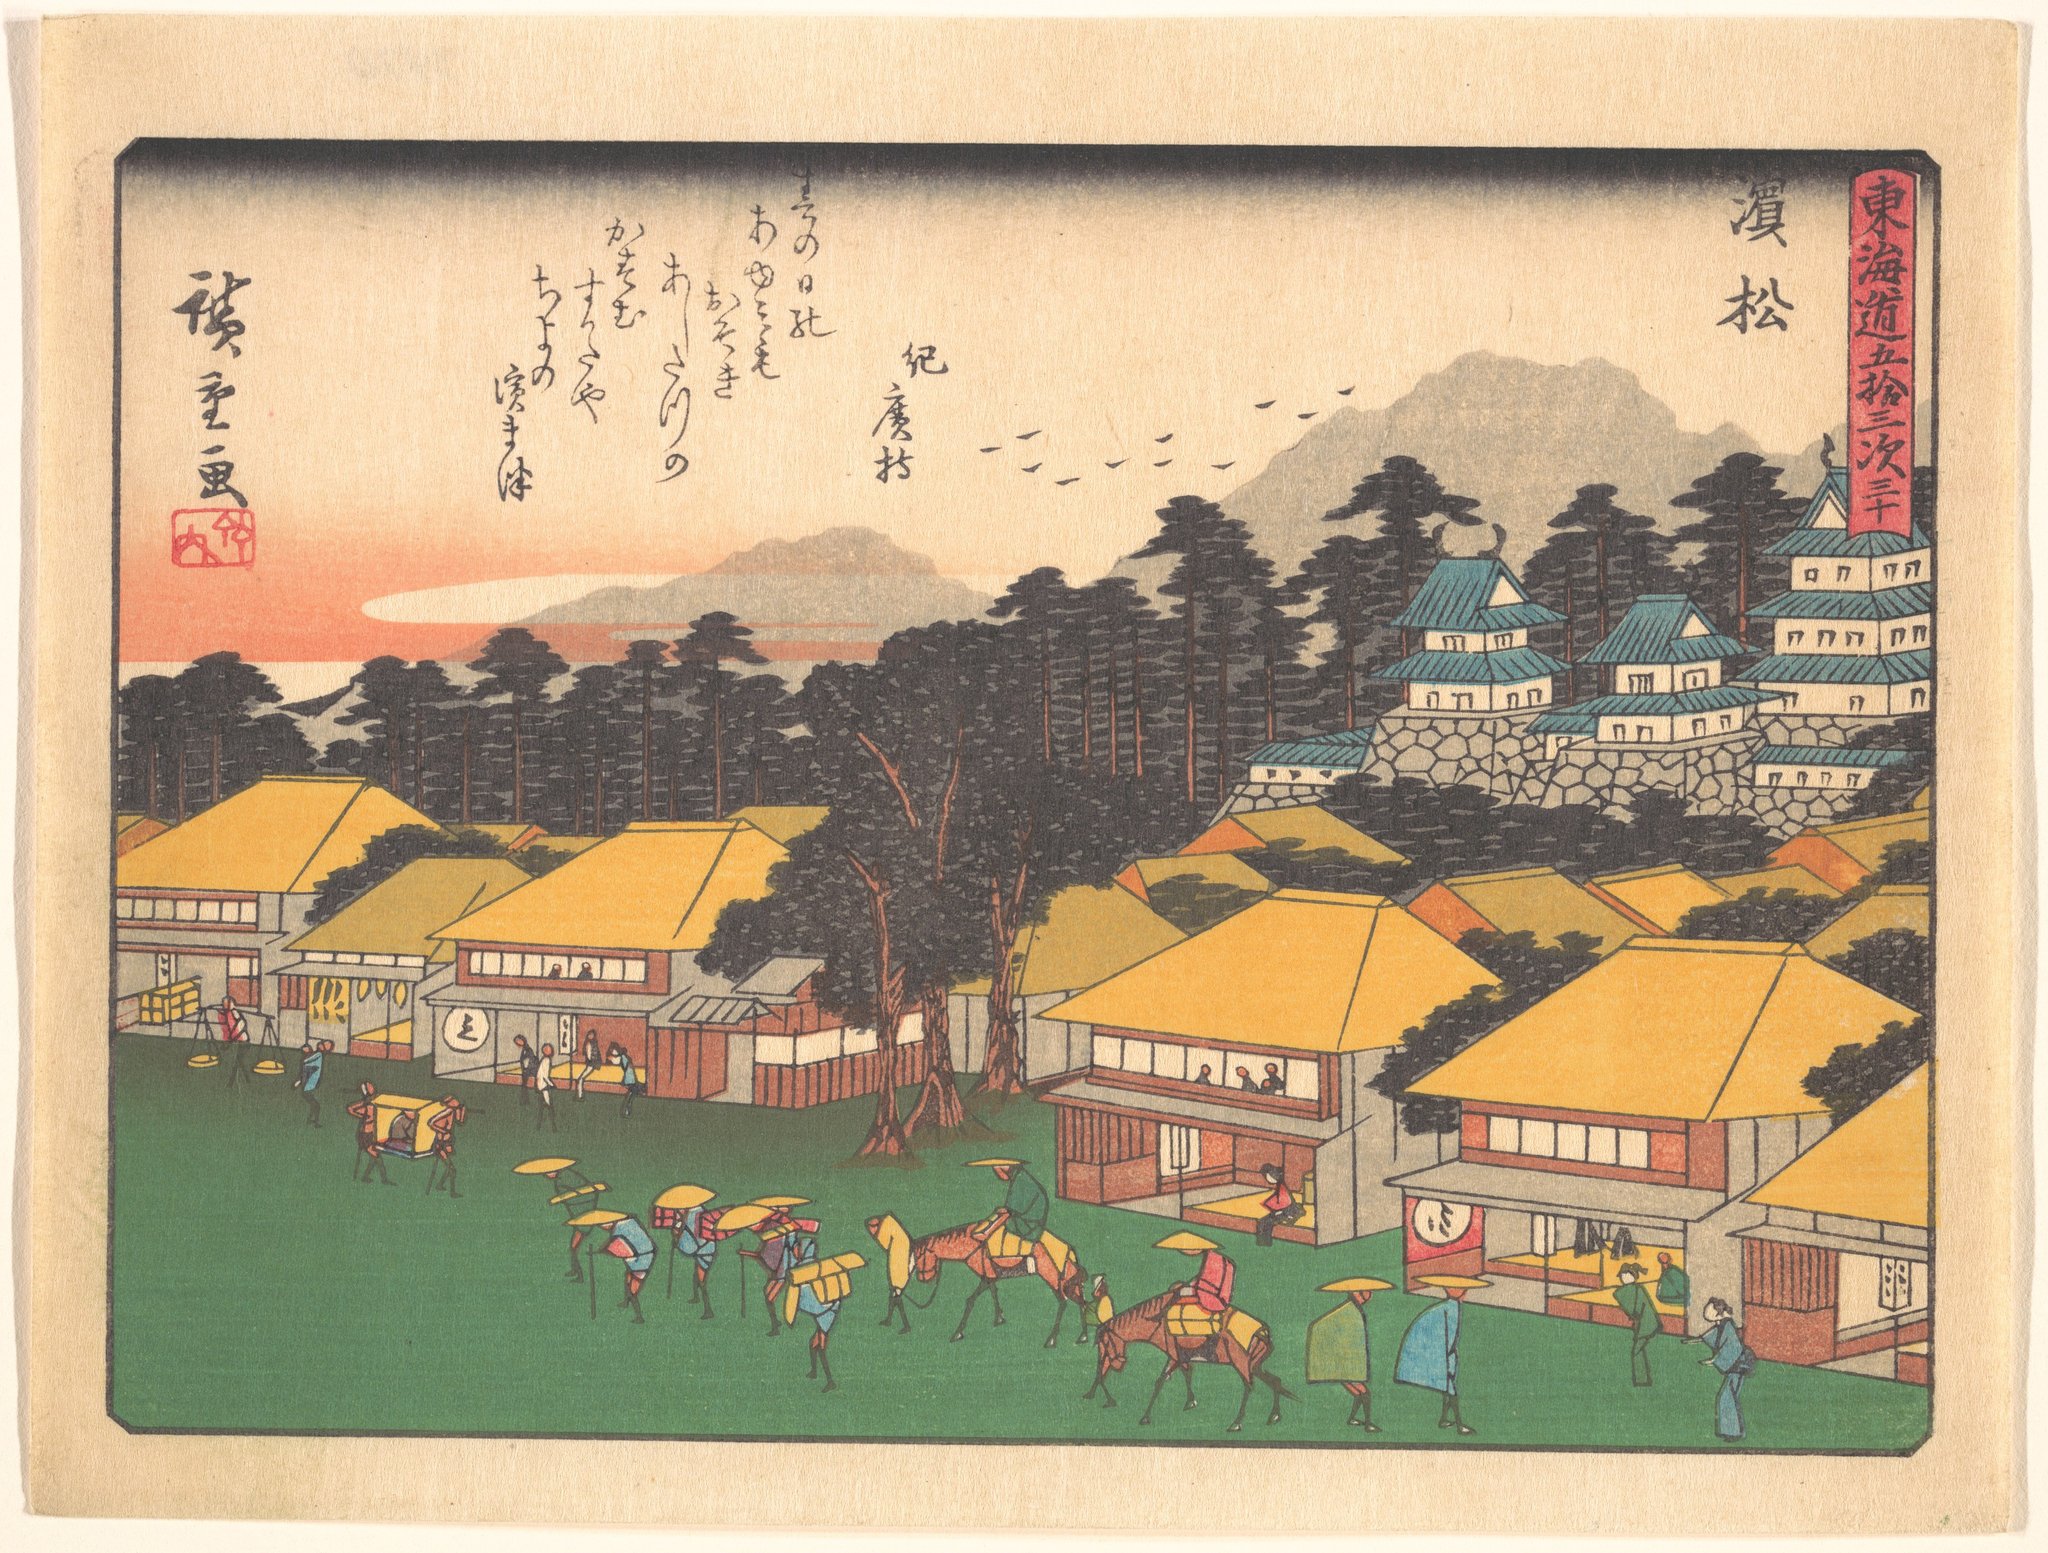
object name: print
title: 東海道五十三次 浜松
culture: japanese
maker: utagawa hiroshige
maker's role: artist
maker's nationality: japanese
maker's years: 1797-1858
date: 1901-1933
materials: ink, paper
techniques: woodblock print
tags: human figures,houses,horses,trees,working